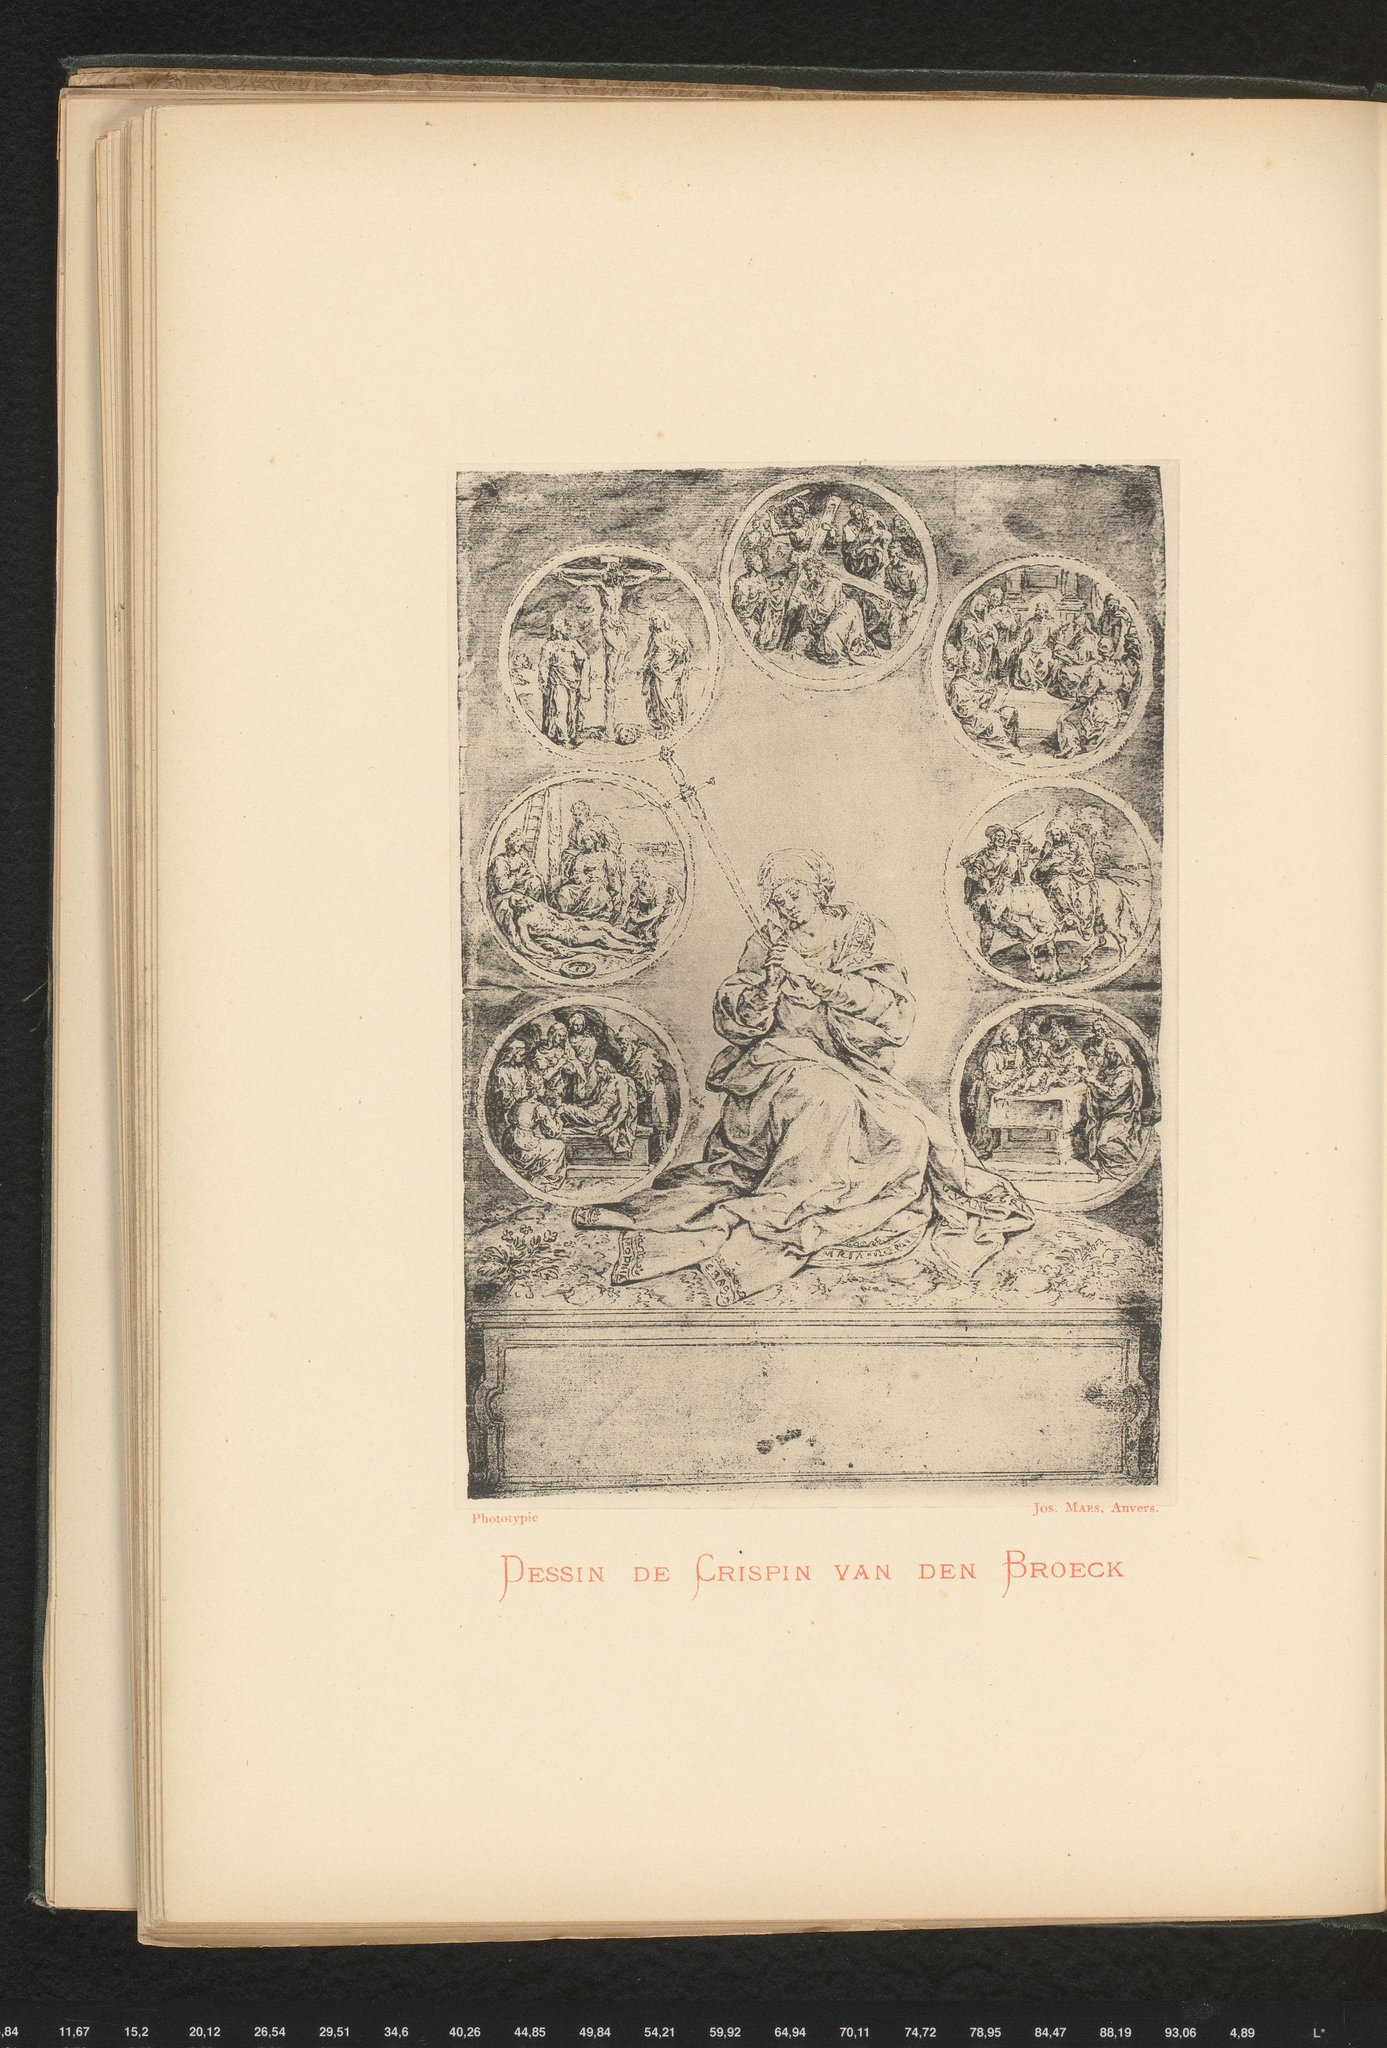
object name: photomechanical print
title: Reproductie van een ontwerp van Maria en het leven en lijden van Jezus door Crispijn van den Broeck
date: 1877-1882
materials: paper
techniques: photograph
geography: antwerp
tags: christ, sitting figures of mary (alone)